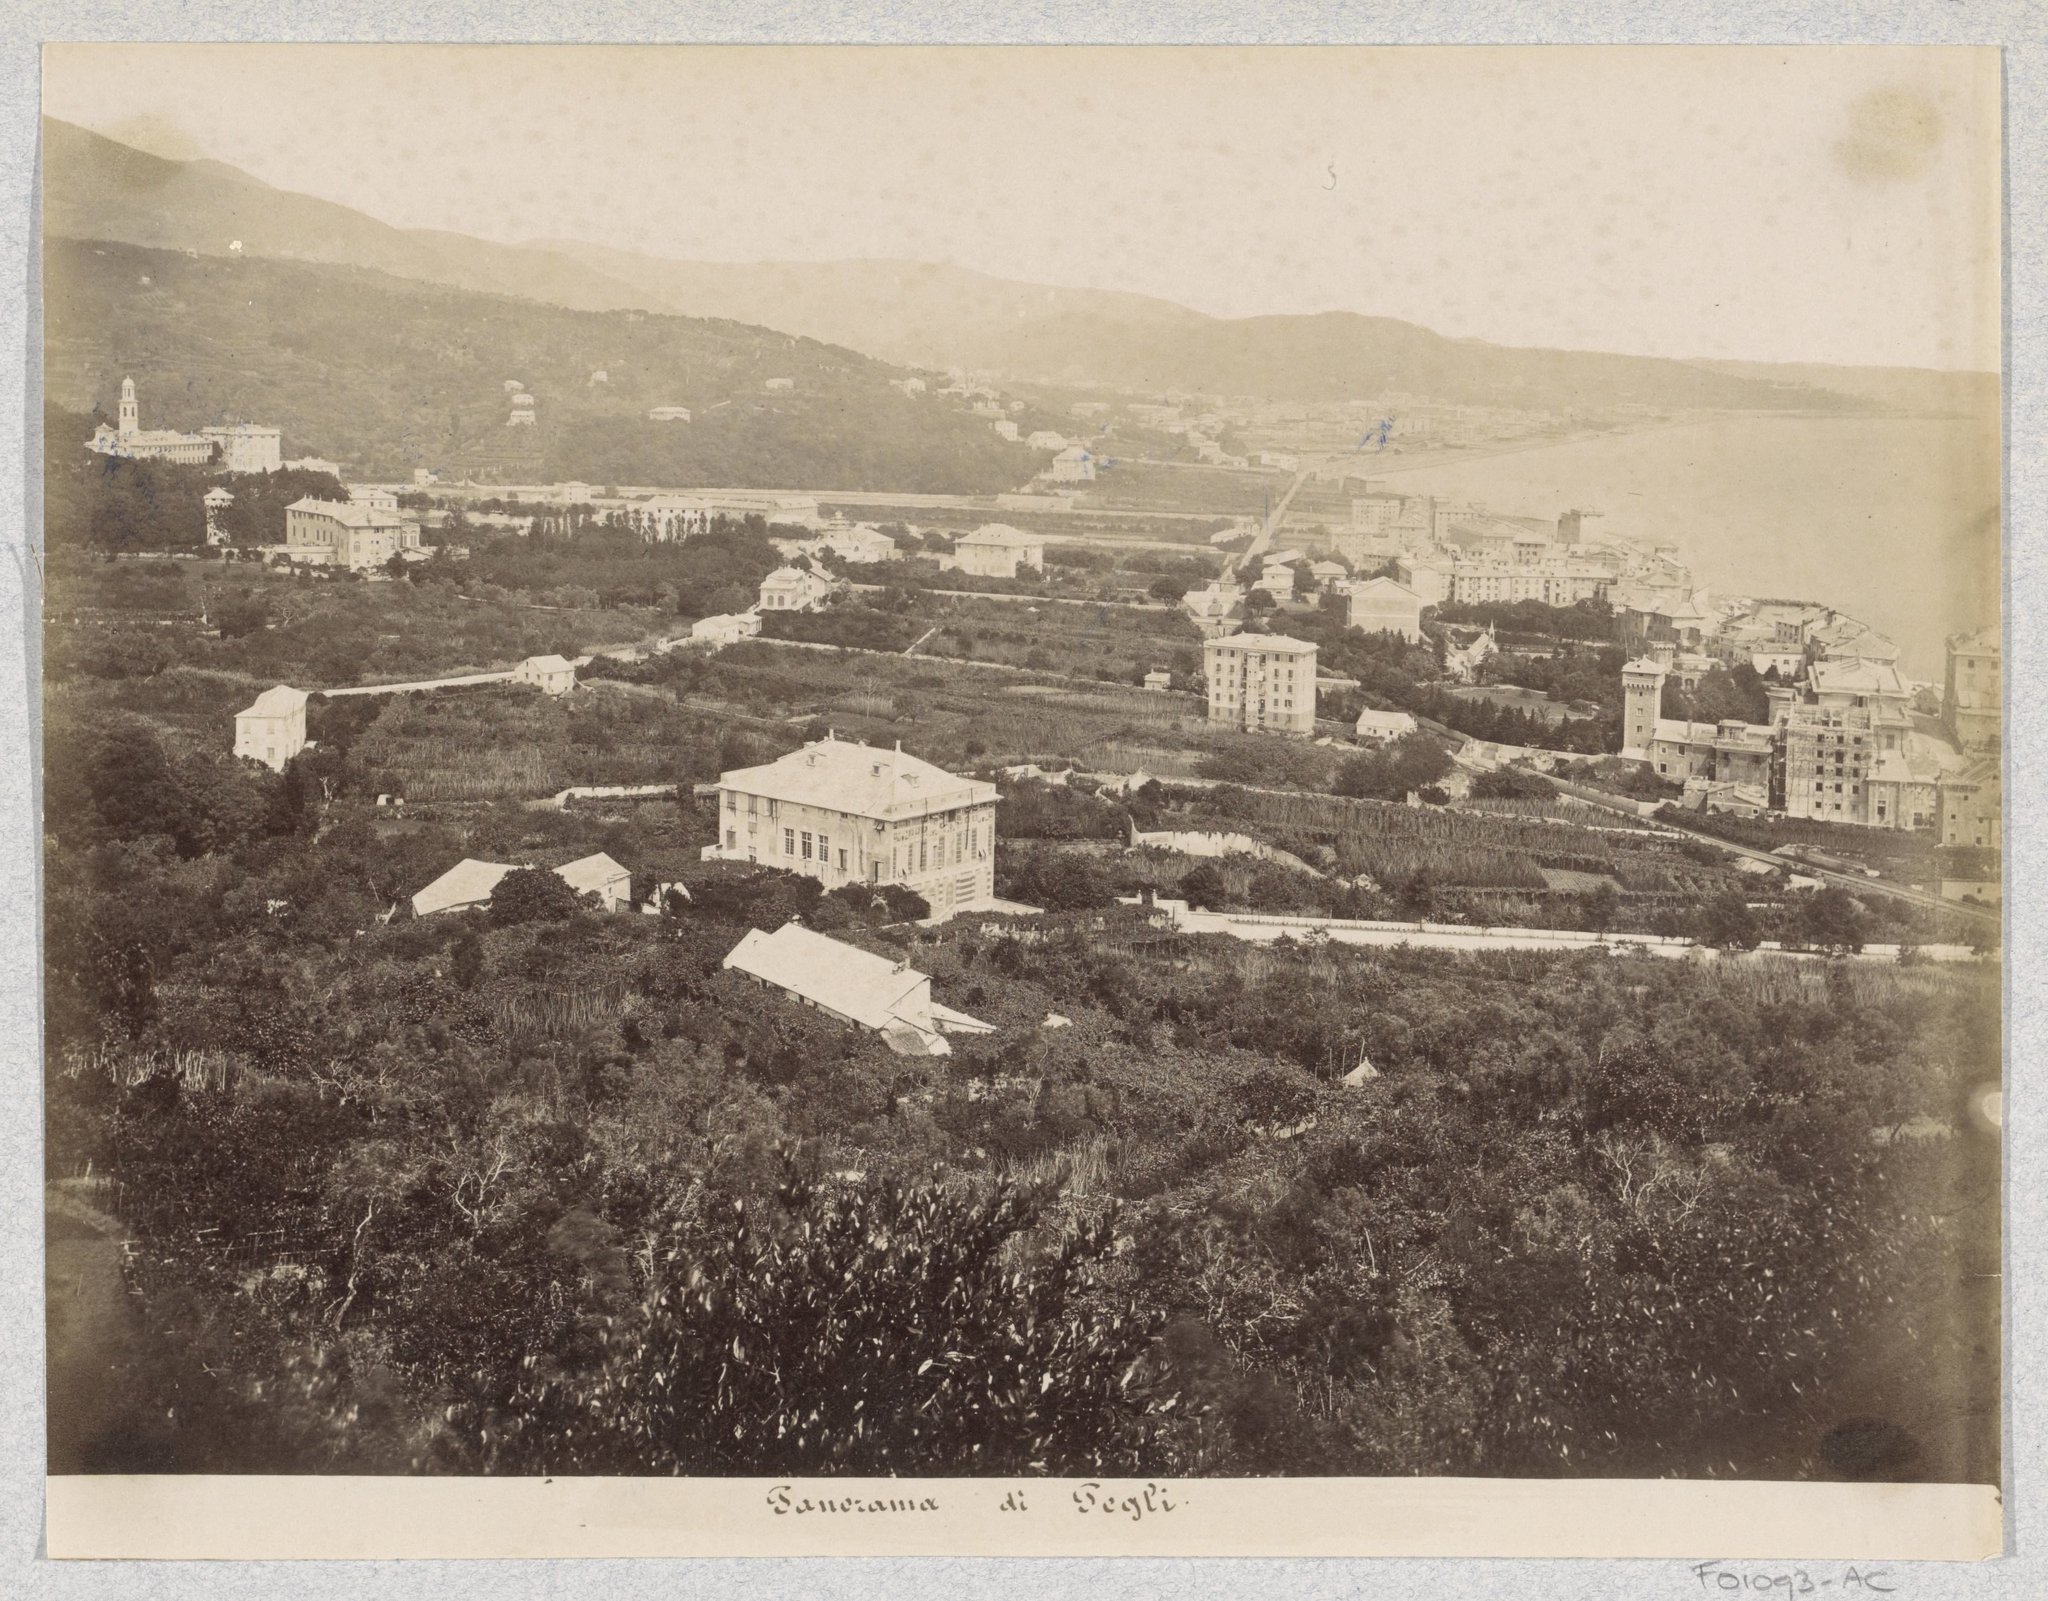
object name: photograph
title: Panorama di Pegli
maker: celestino degoix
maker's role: fotograaf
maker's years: 1825-1902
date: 1870-1890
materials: paper, photographic support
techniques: albumen print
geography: pegli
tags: prospect of village, silhouette of village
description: Onderdeel van Reisalbum met foto's van bezienswaardigheden in Genua, Florence en Venetië.